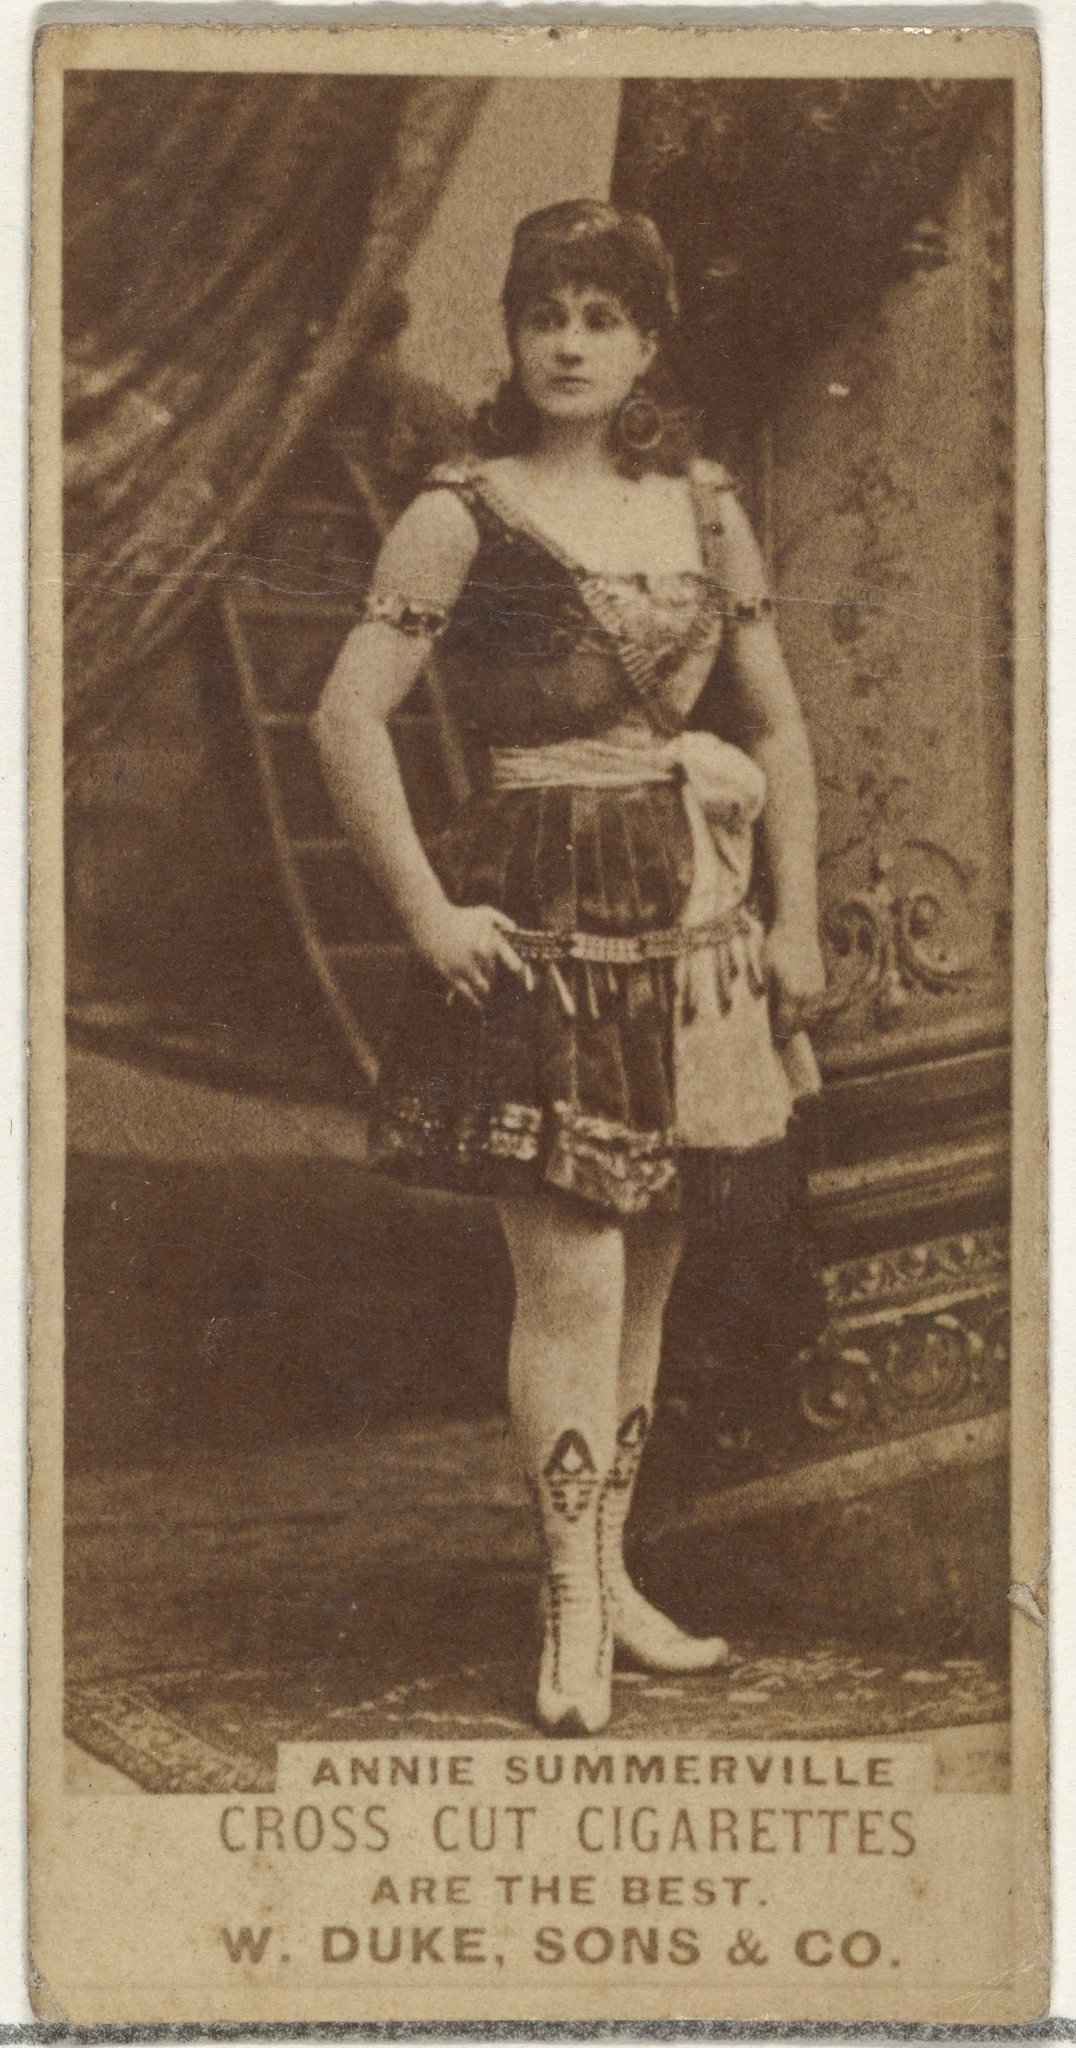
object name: photograph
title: Annie Summerville, from the Actors and Actresses series (N145-3) issued by Duke Sons & Co. to promote Cross Cut Cigarettes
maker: w. duke, sons & co.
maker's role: publisher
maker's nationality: american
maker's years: 1870-1920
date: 1880-1889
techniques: albumen silver print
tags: portraits,women,actresses